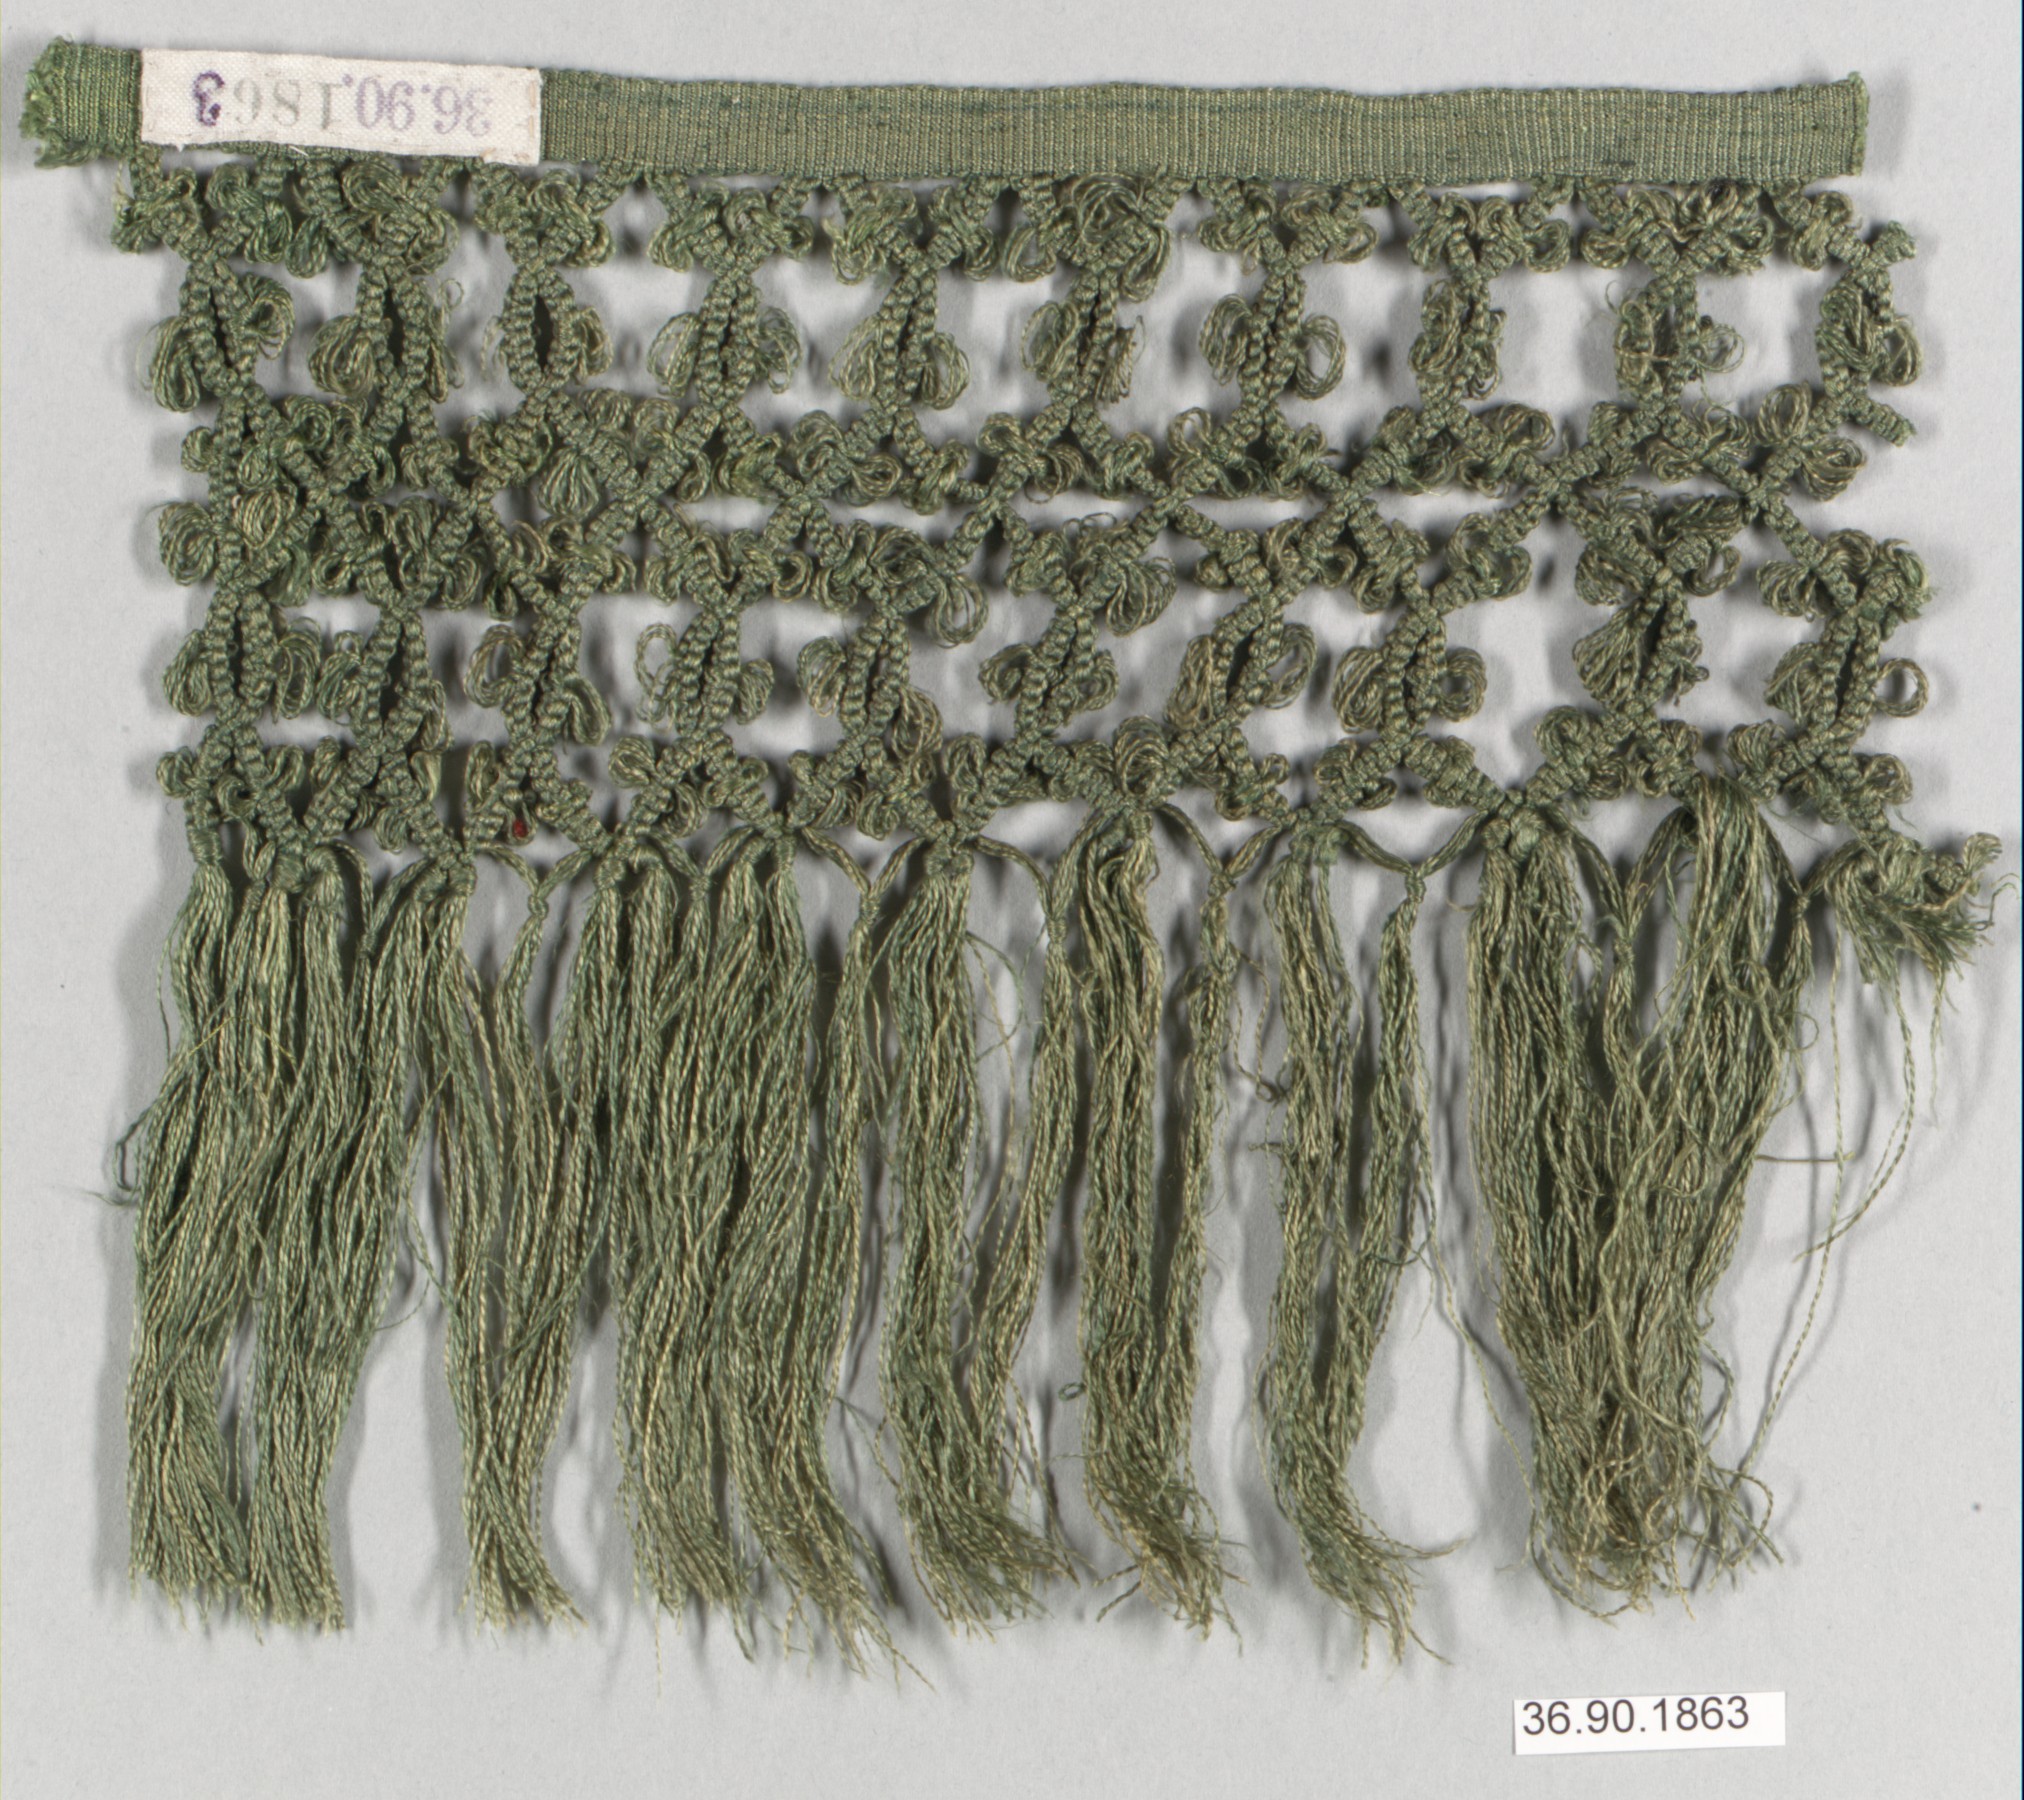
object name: fringe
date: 1701-1800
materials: silk